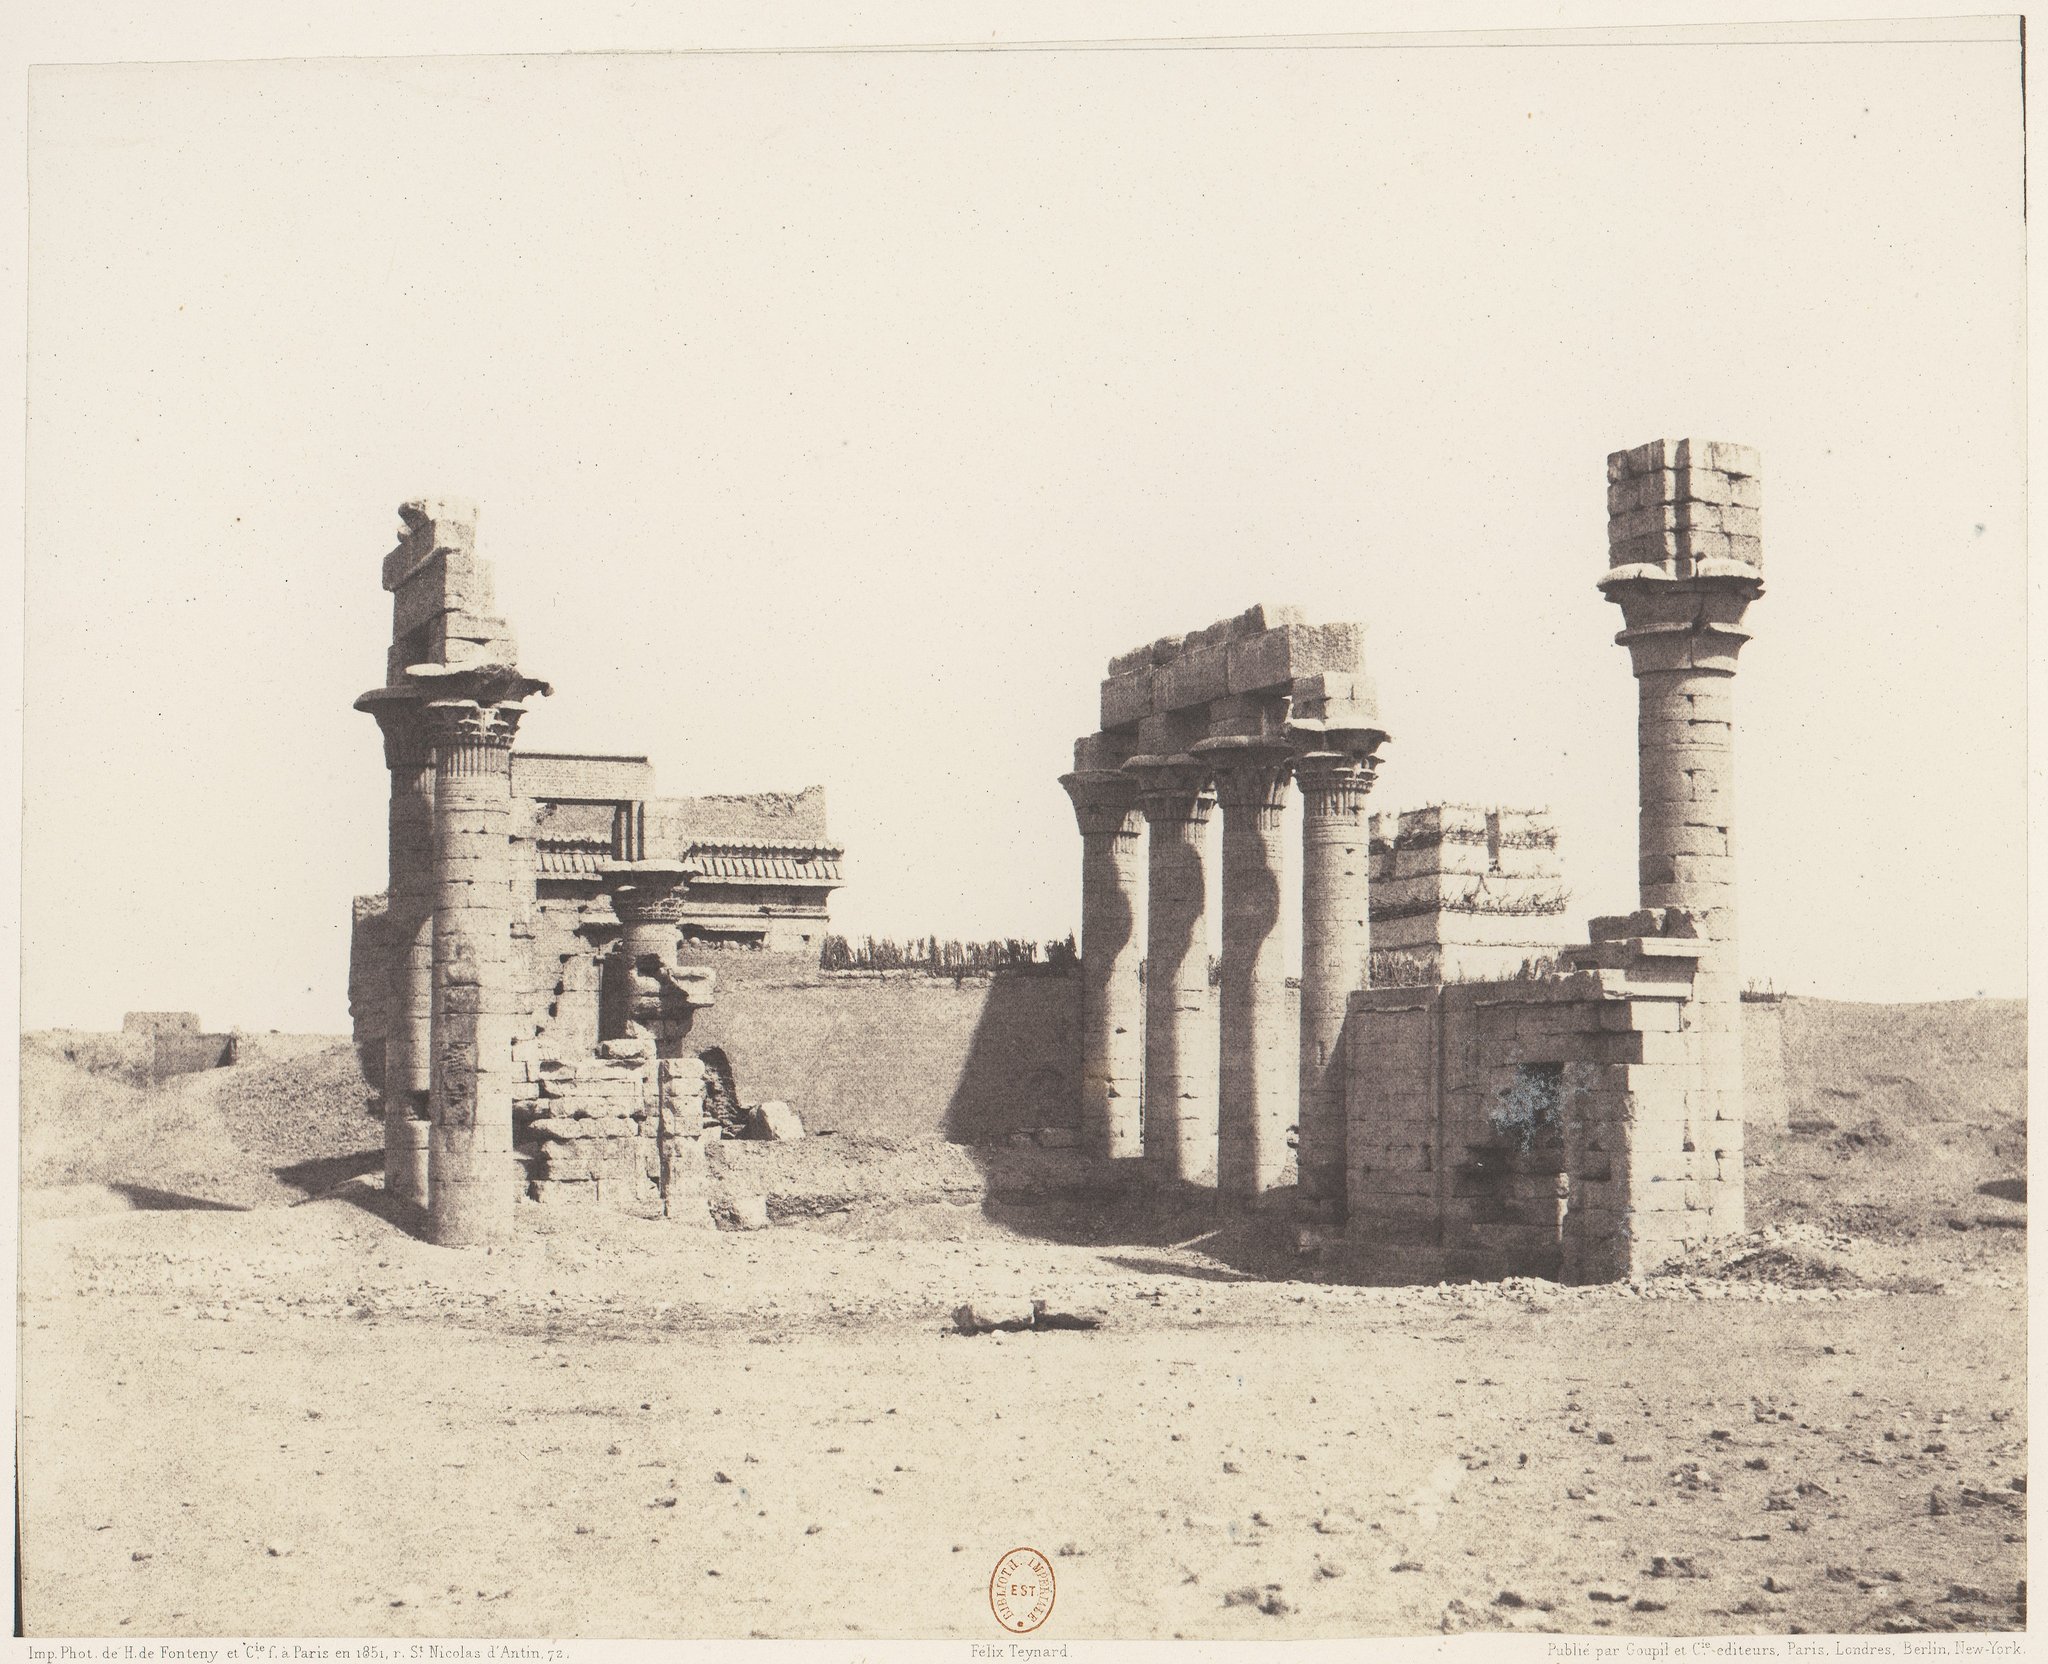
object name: photograph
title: Erment (Hermonthis), Vue Générale des Ruines -Temple et Mammisi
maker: félix teynard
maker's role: artist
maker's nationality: french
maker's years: 1817-1892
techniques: paper negative, salted paper print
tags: columns,ruins